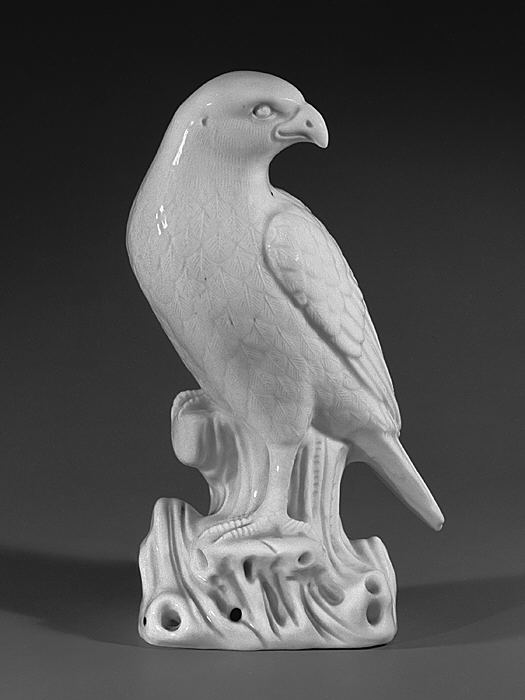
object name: figure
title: Figure of a hawk (one of a pair)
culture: chinese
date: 1767-1800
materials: glaze, porcelain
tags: hawks